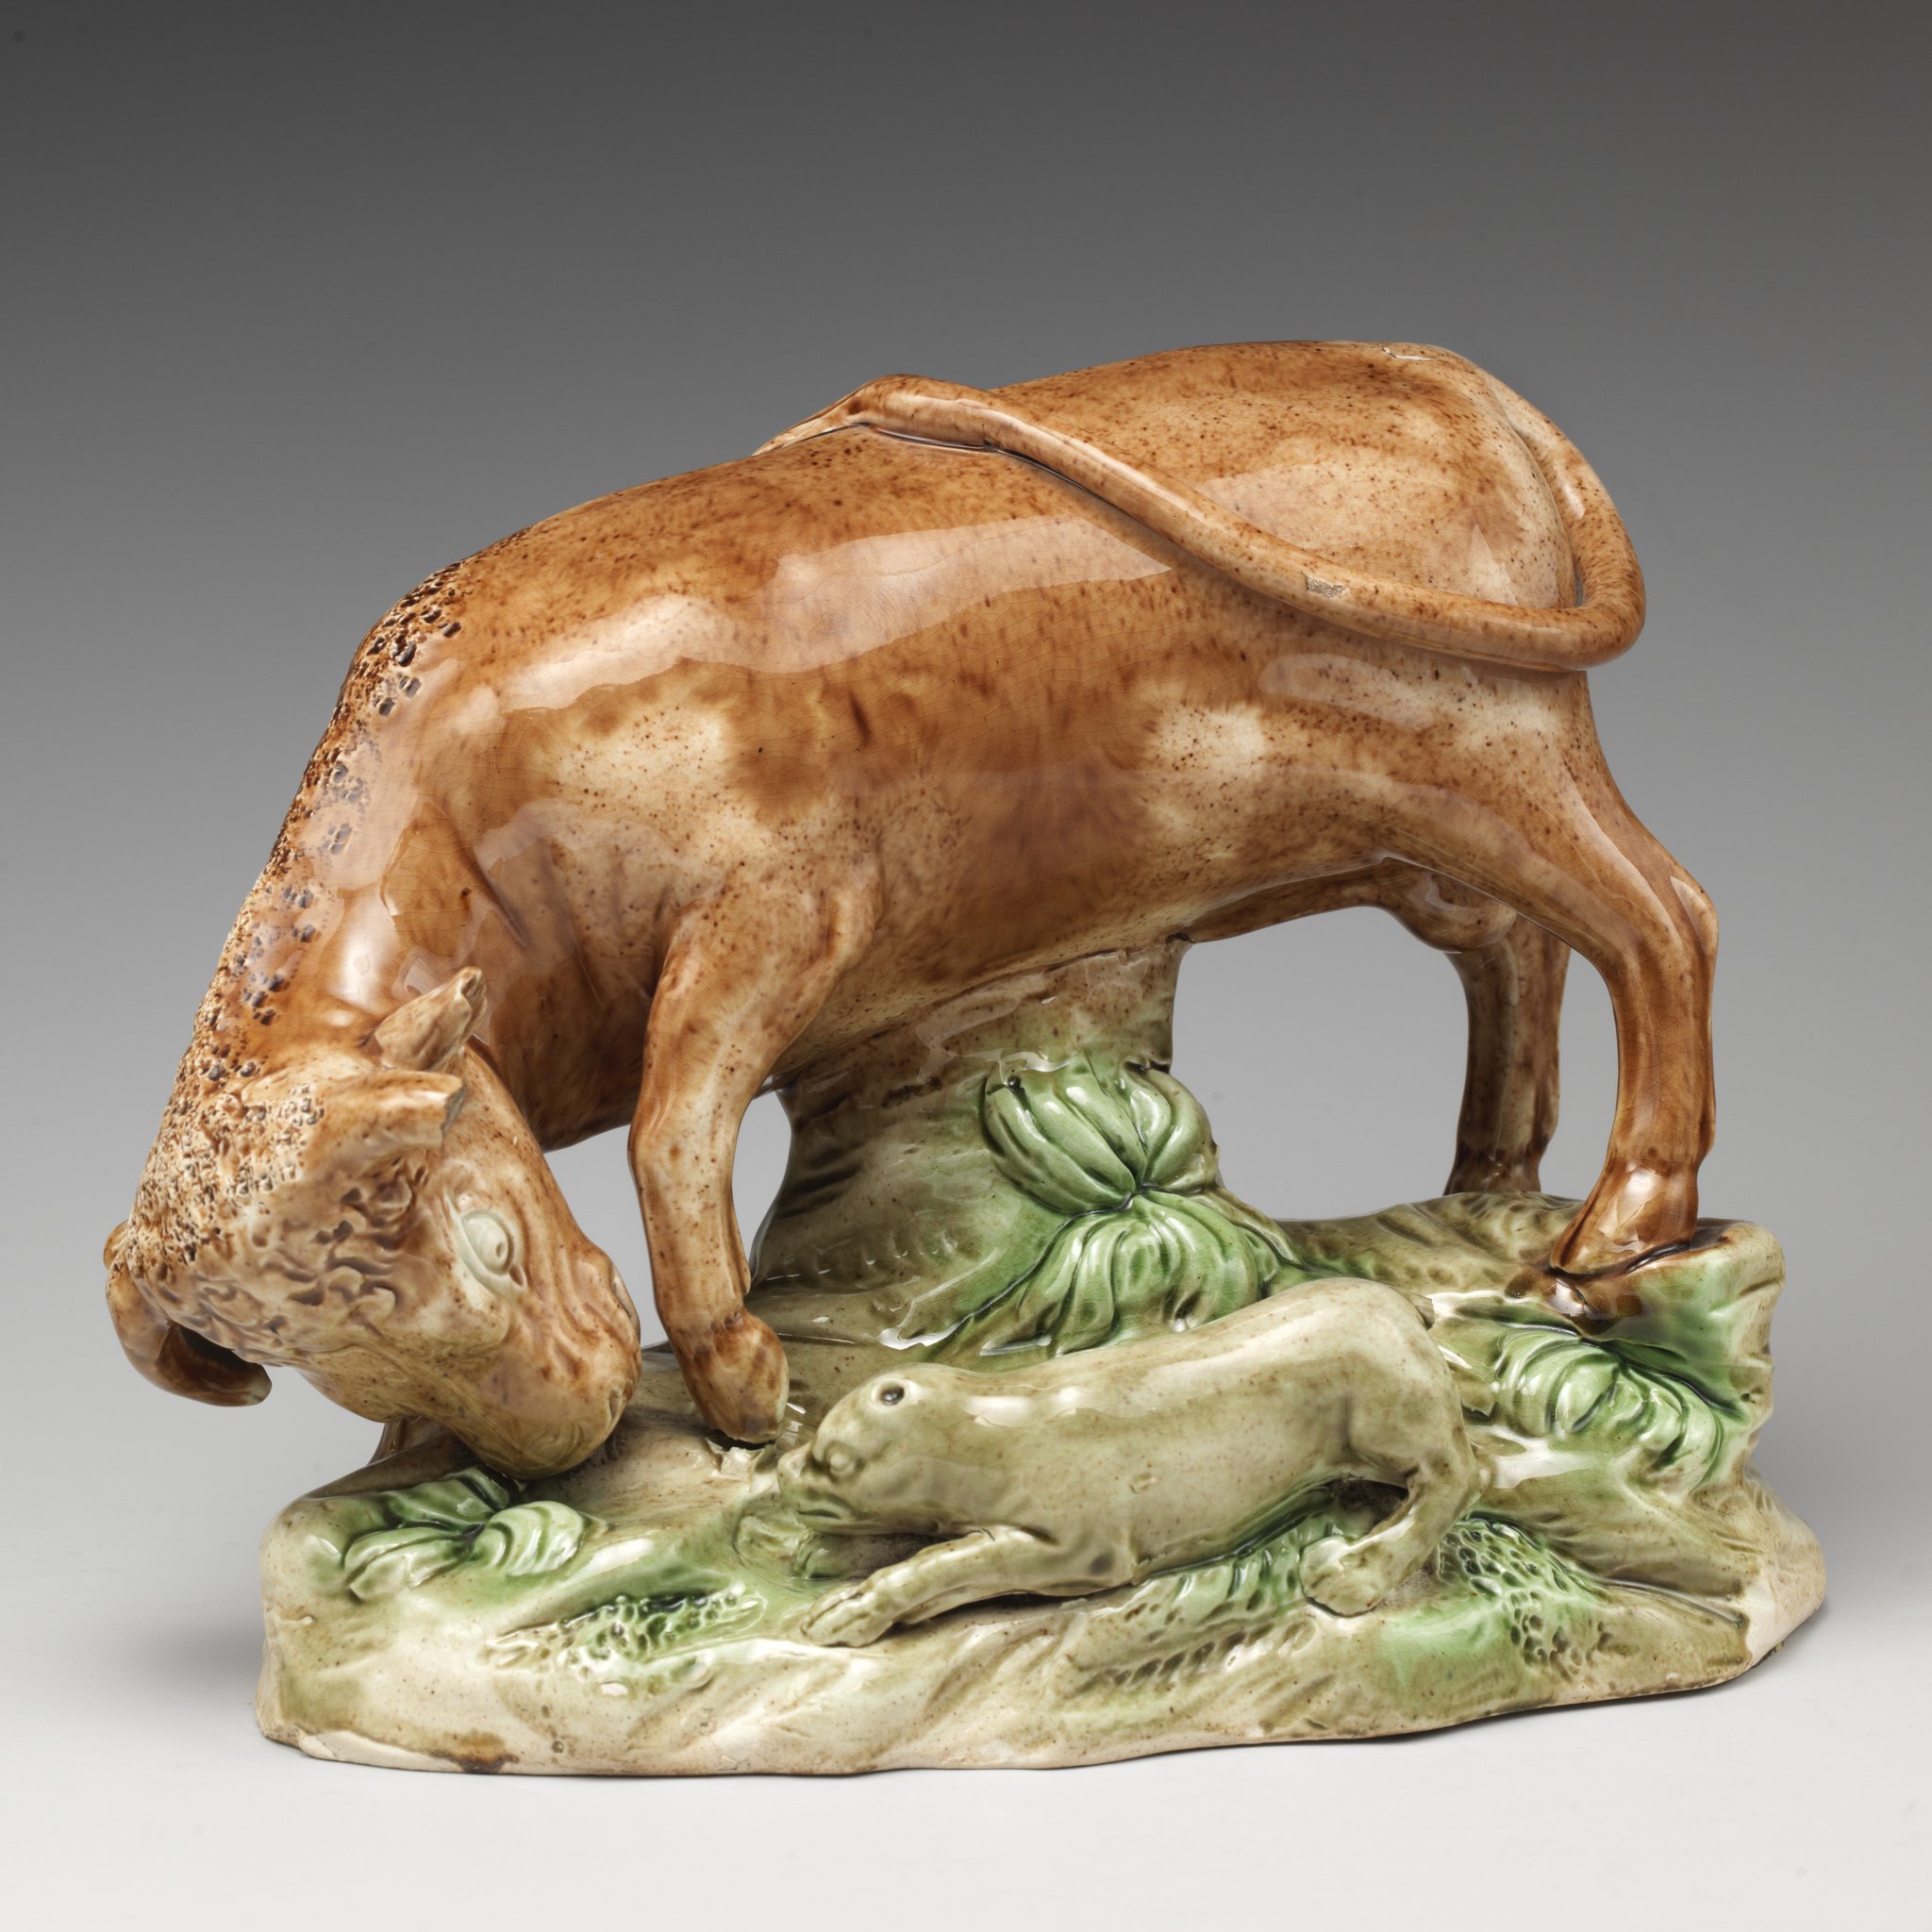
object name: group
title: Bullbaiting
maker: ralph wood the younger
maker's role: maker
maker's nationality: british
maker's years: 1748-1795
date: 1770-1780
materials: earthenware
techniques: glazing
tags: bulls,dogs,leaves